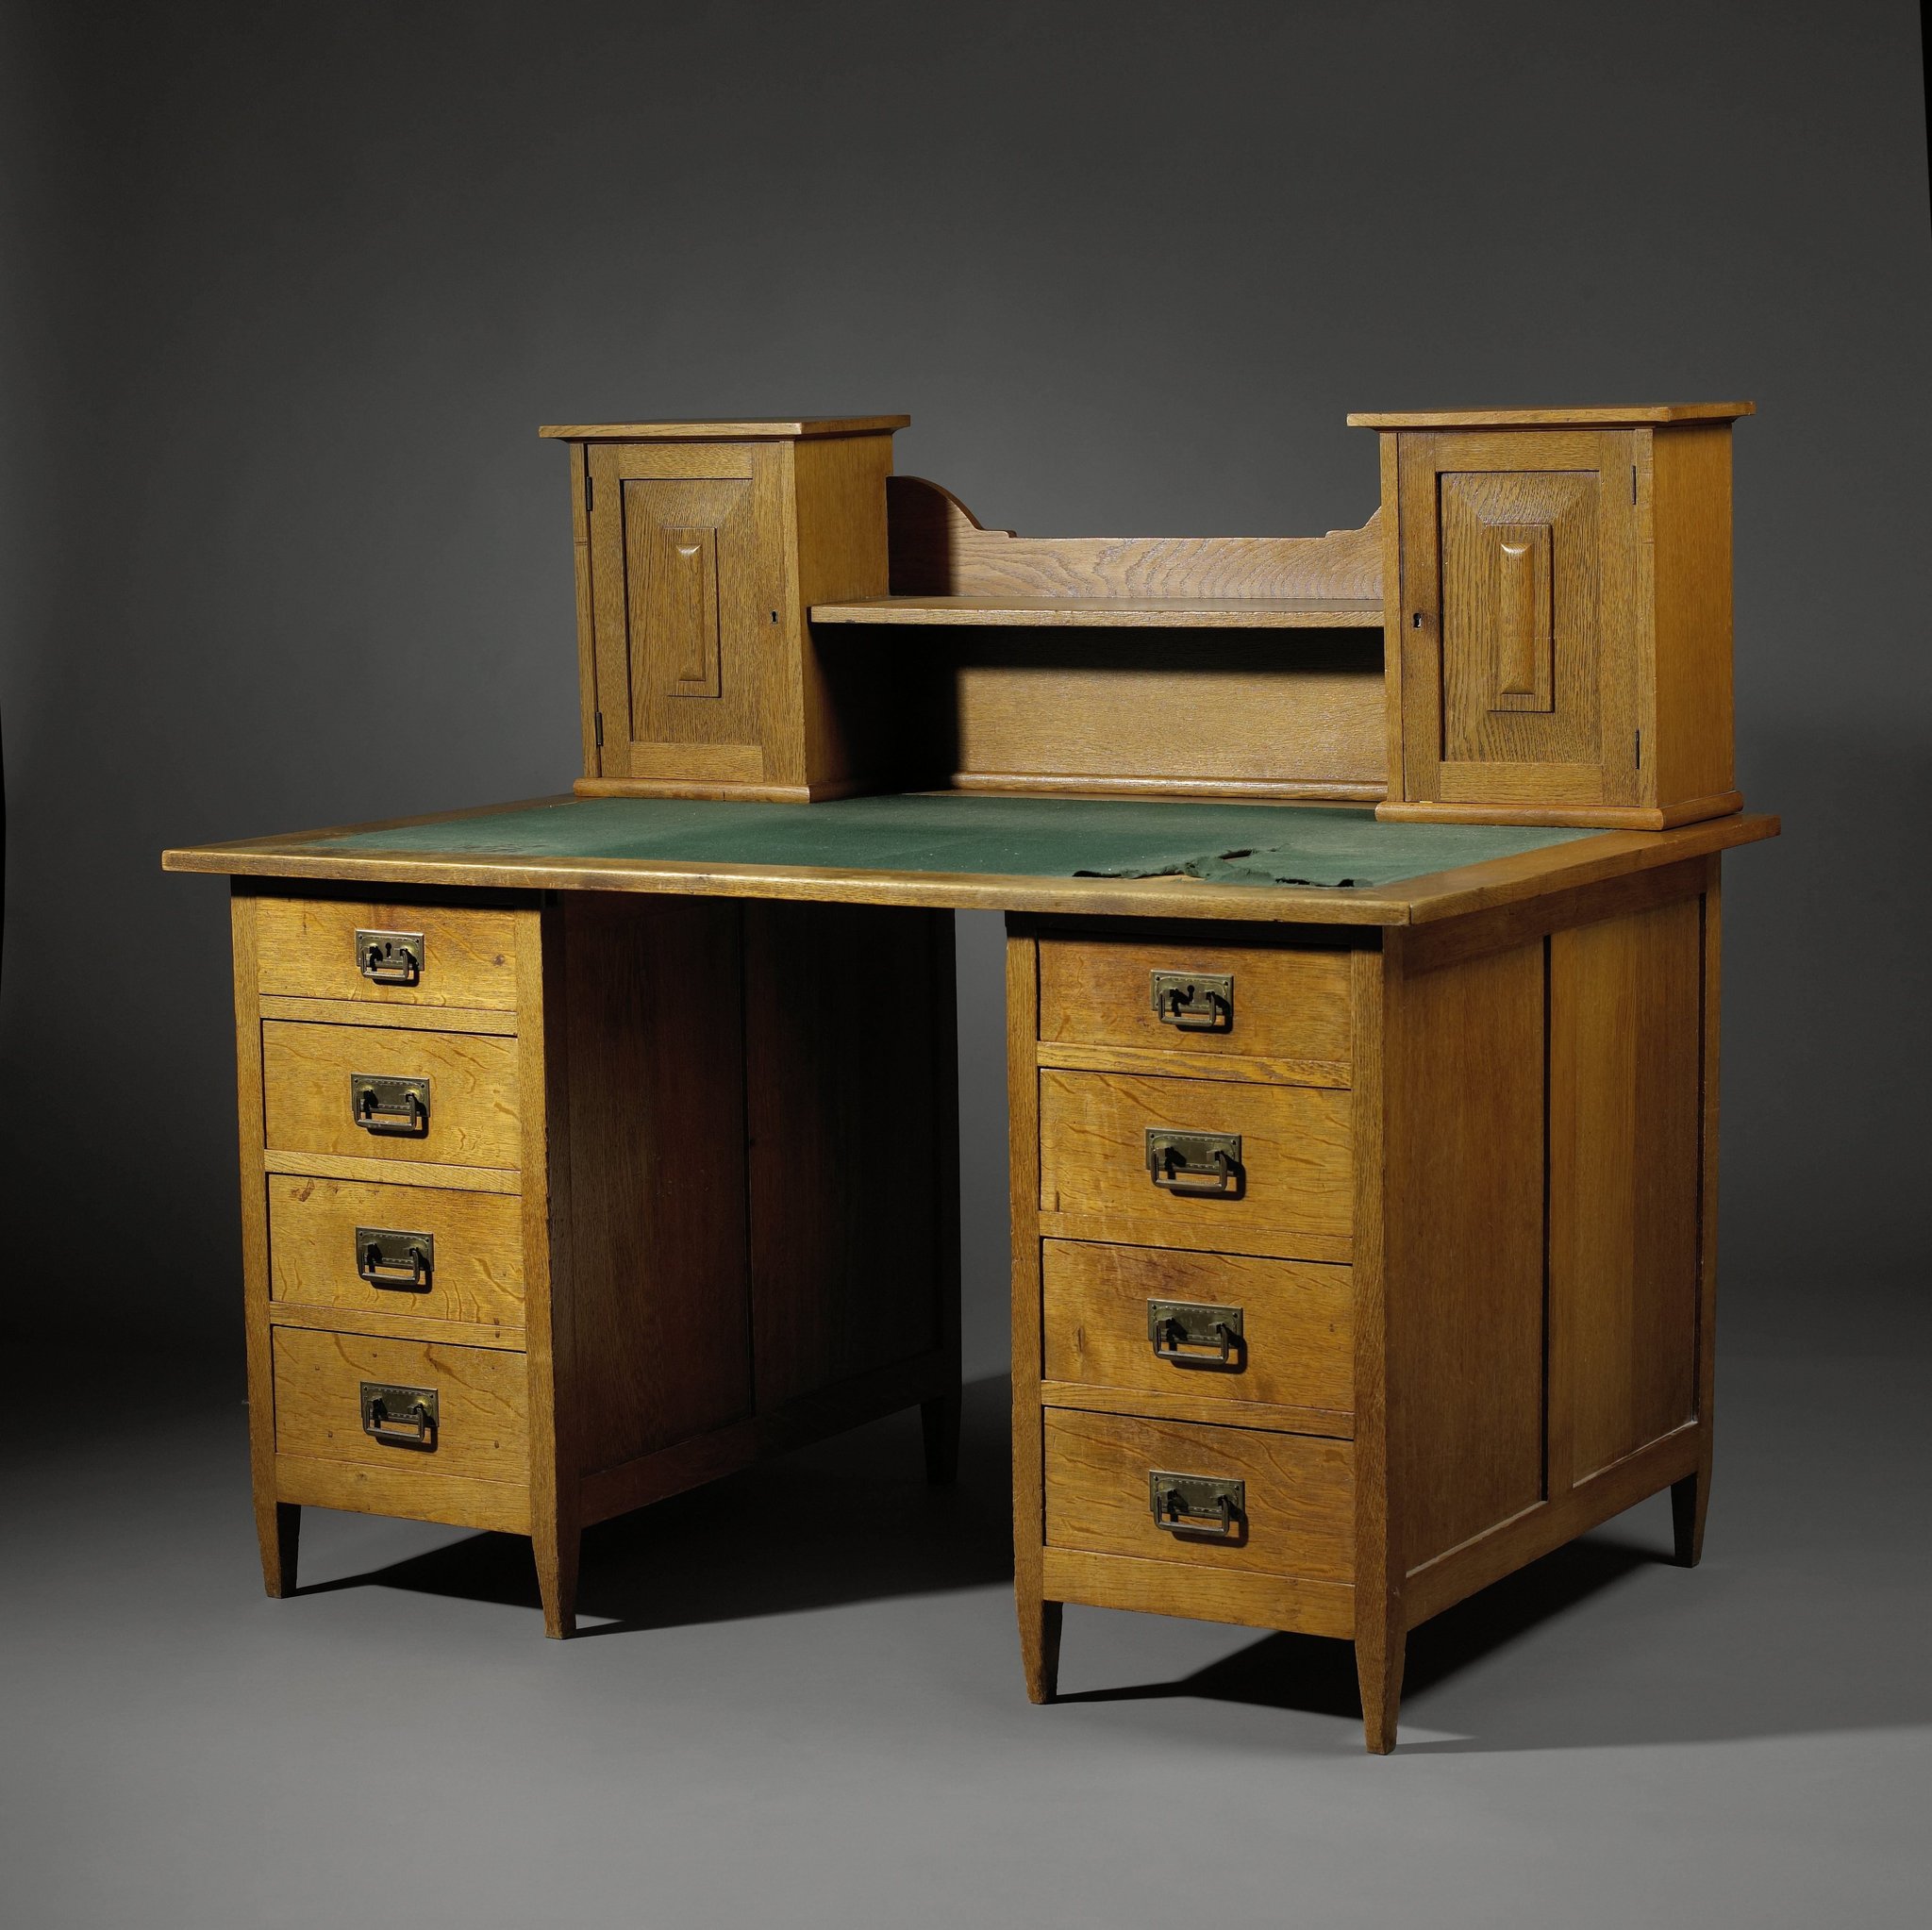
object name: desk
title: Bureau van Willem Drees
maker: arnold h. jansen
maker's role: interieurontwerper, meubelontwerper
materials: textile, wood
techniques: woodworking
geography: amsterdam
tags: the hague, willem drees, amsterdam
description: In 1967 W. Drees presented several items to the Rijksmuseum on loan. In 1991 the Drees family changed this loan into a gift. In 2003 a number of objects were added from the estate of W. Drees.